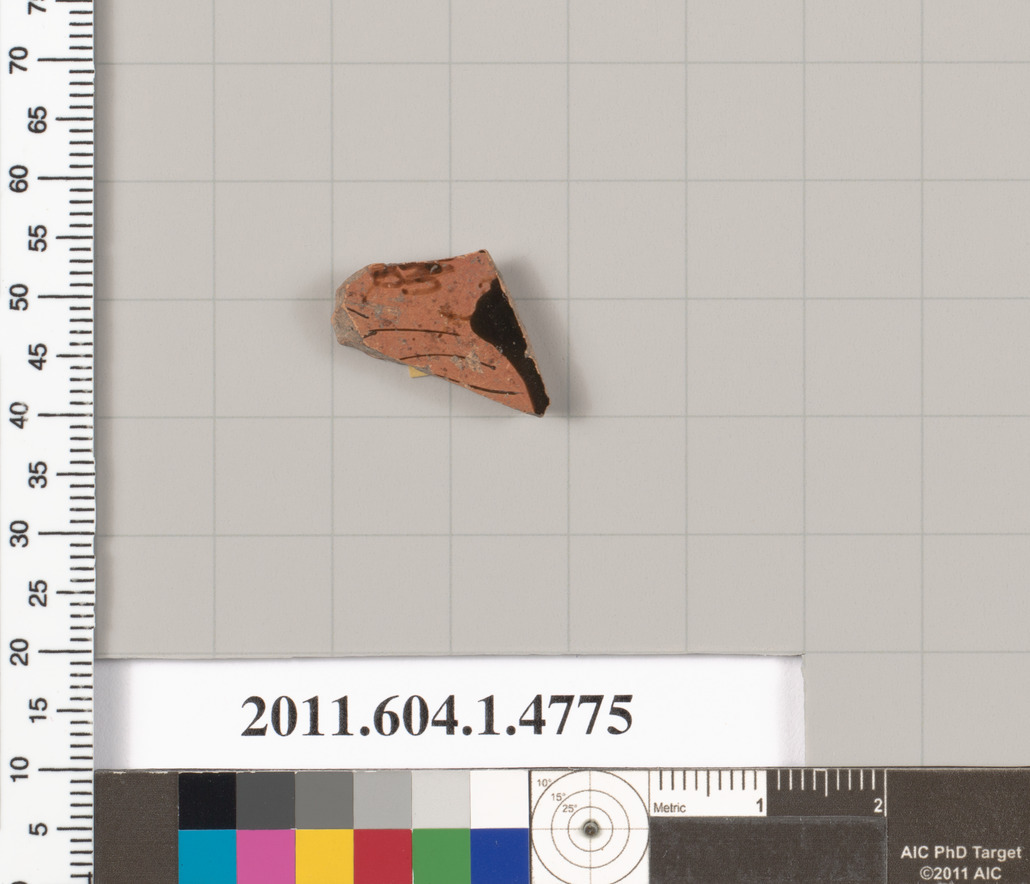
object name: kylix fragment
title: Terracotta fragment of a kylix (drinking cup)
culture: greek, attic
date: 467-435 BCE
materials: terracotta